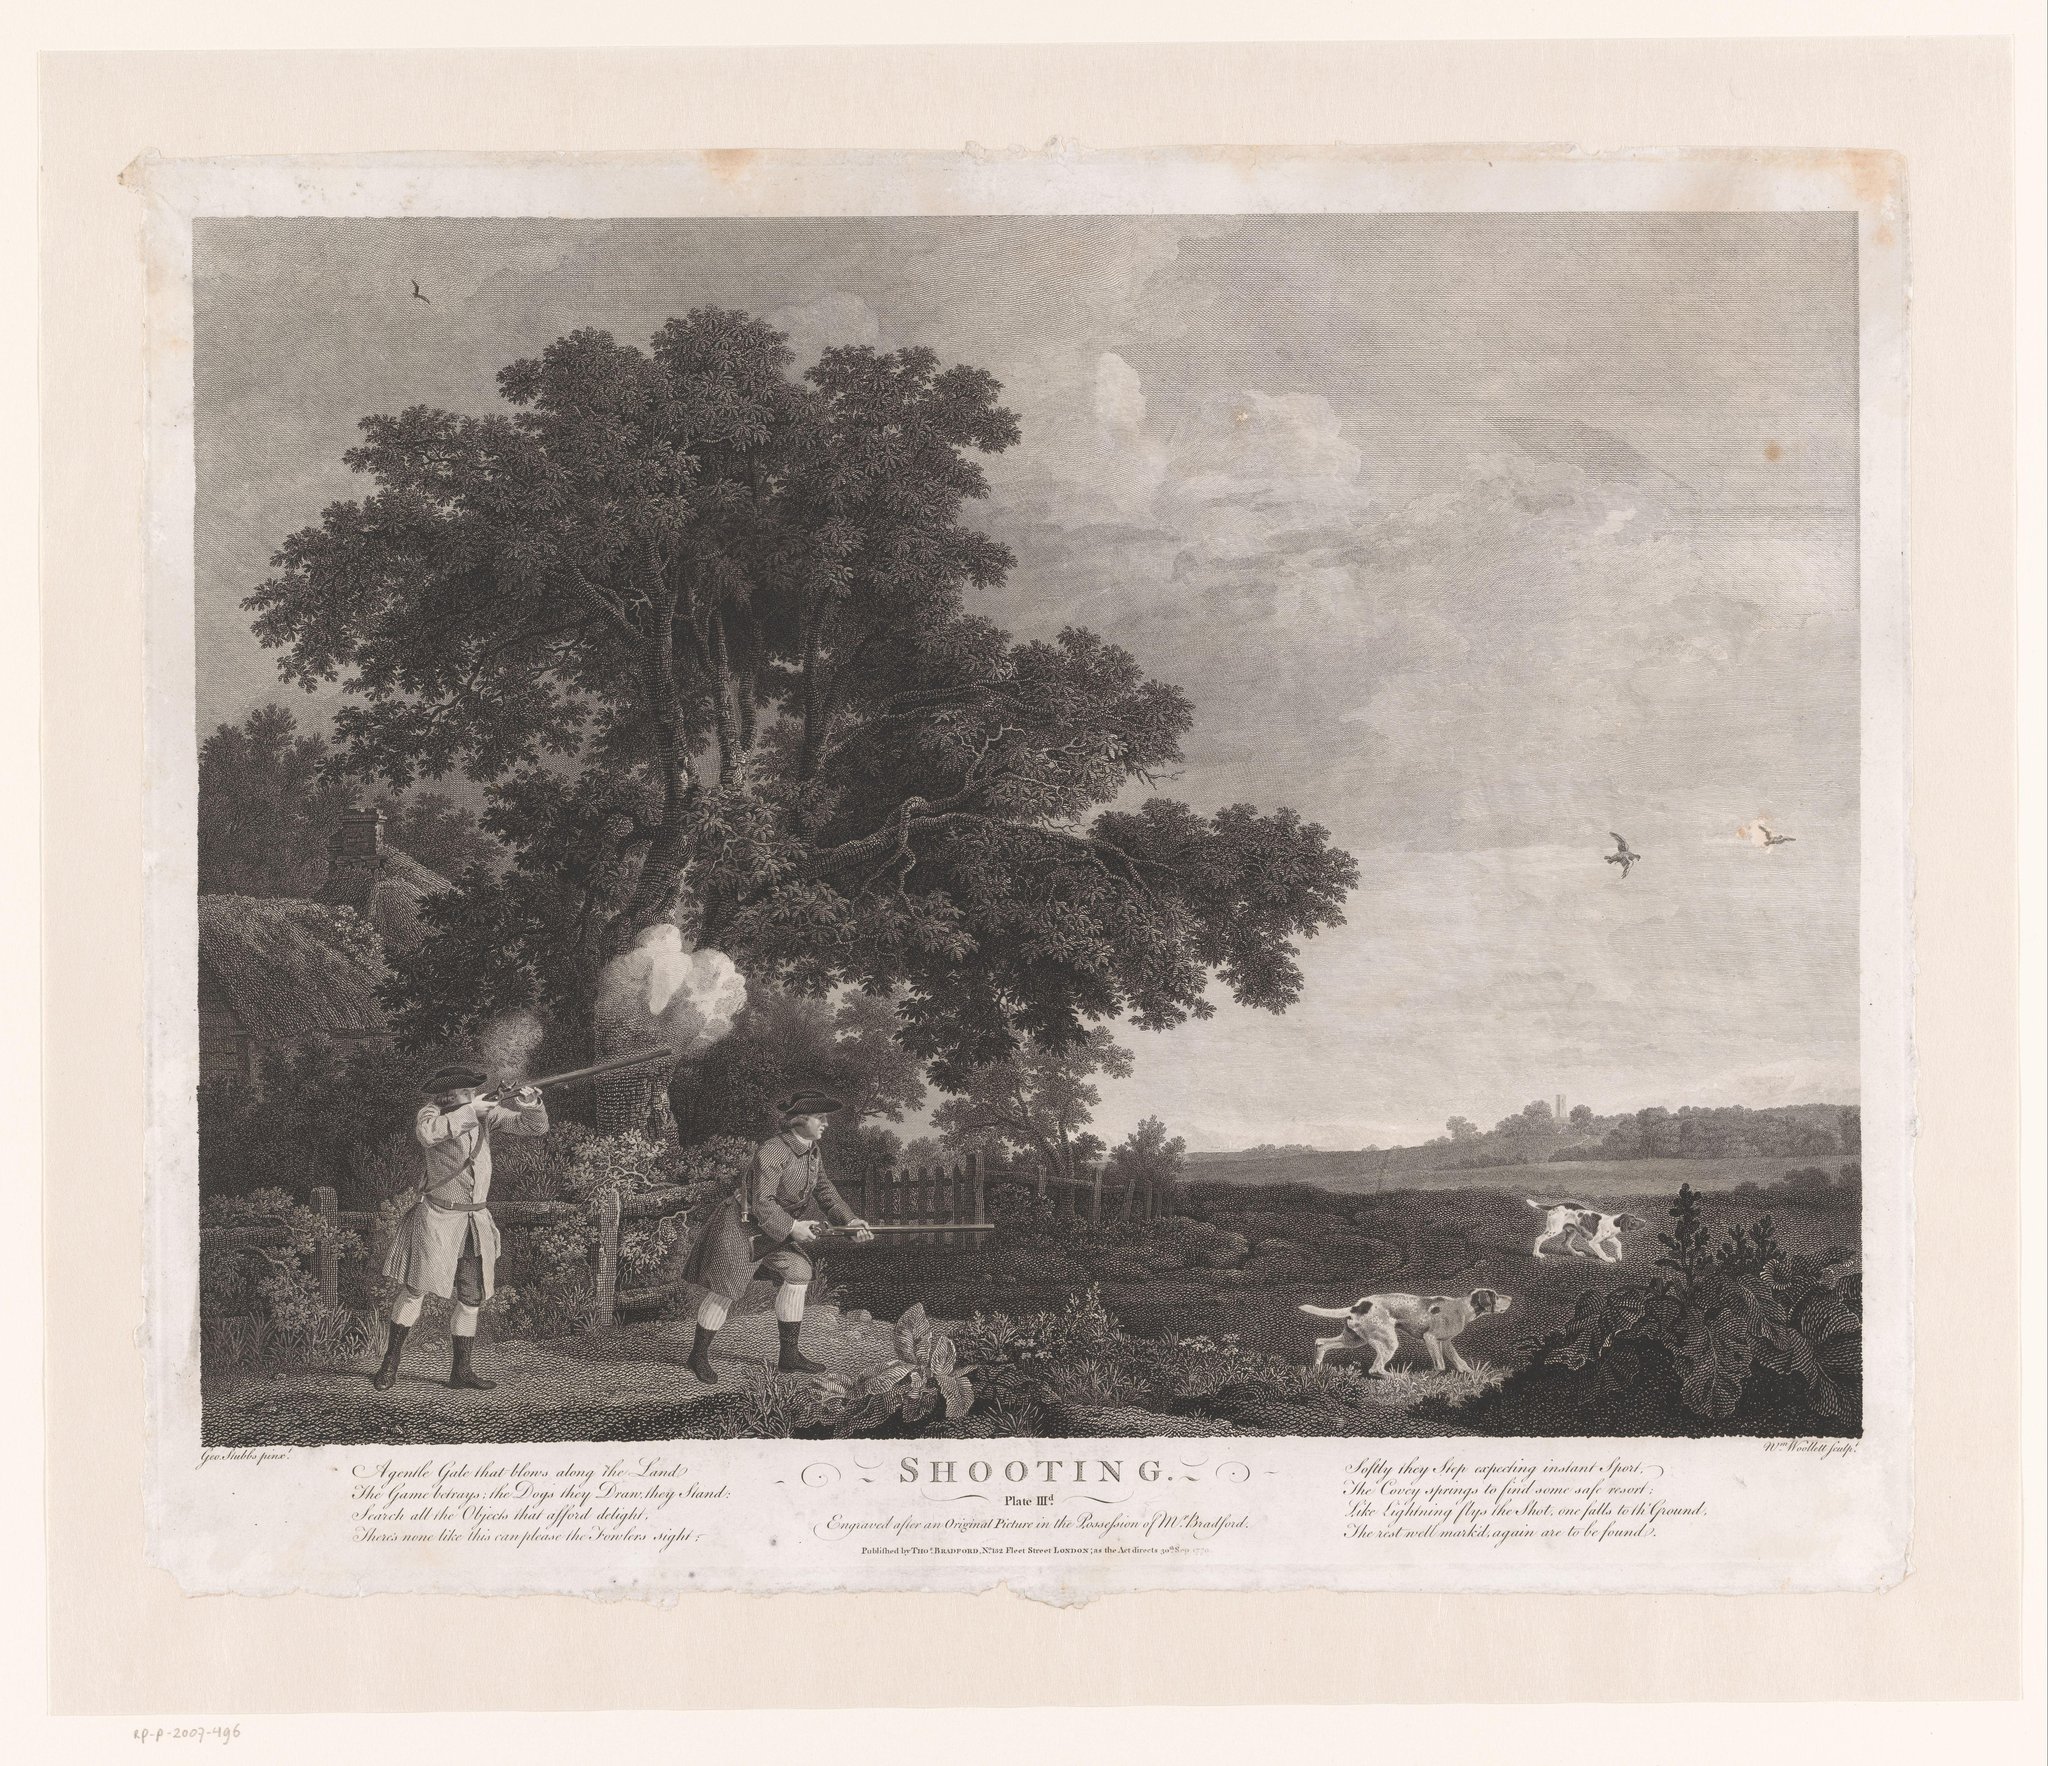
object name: print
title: Shooting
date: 1770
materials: paper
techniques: engraving, etching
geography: london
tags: hunting dogs, bird hunting, cottage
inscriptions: date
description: Naar een schilderij van George Stubbs in The Yale Center for British Art.